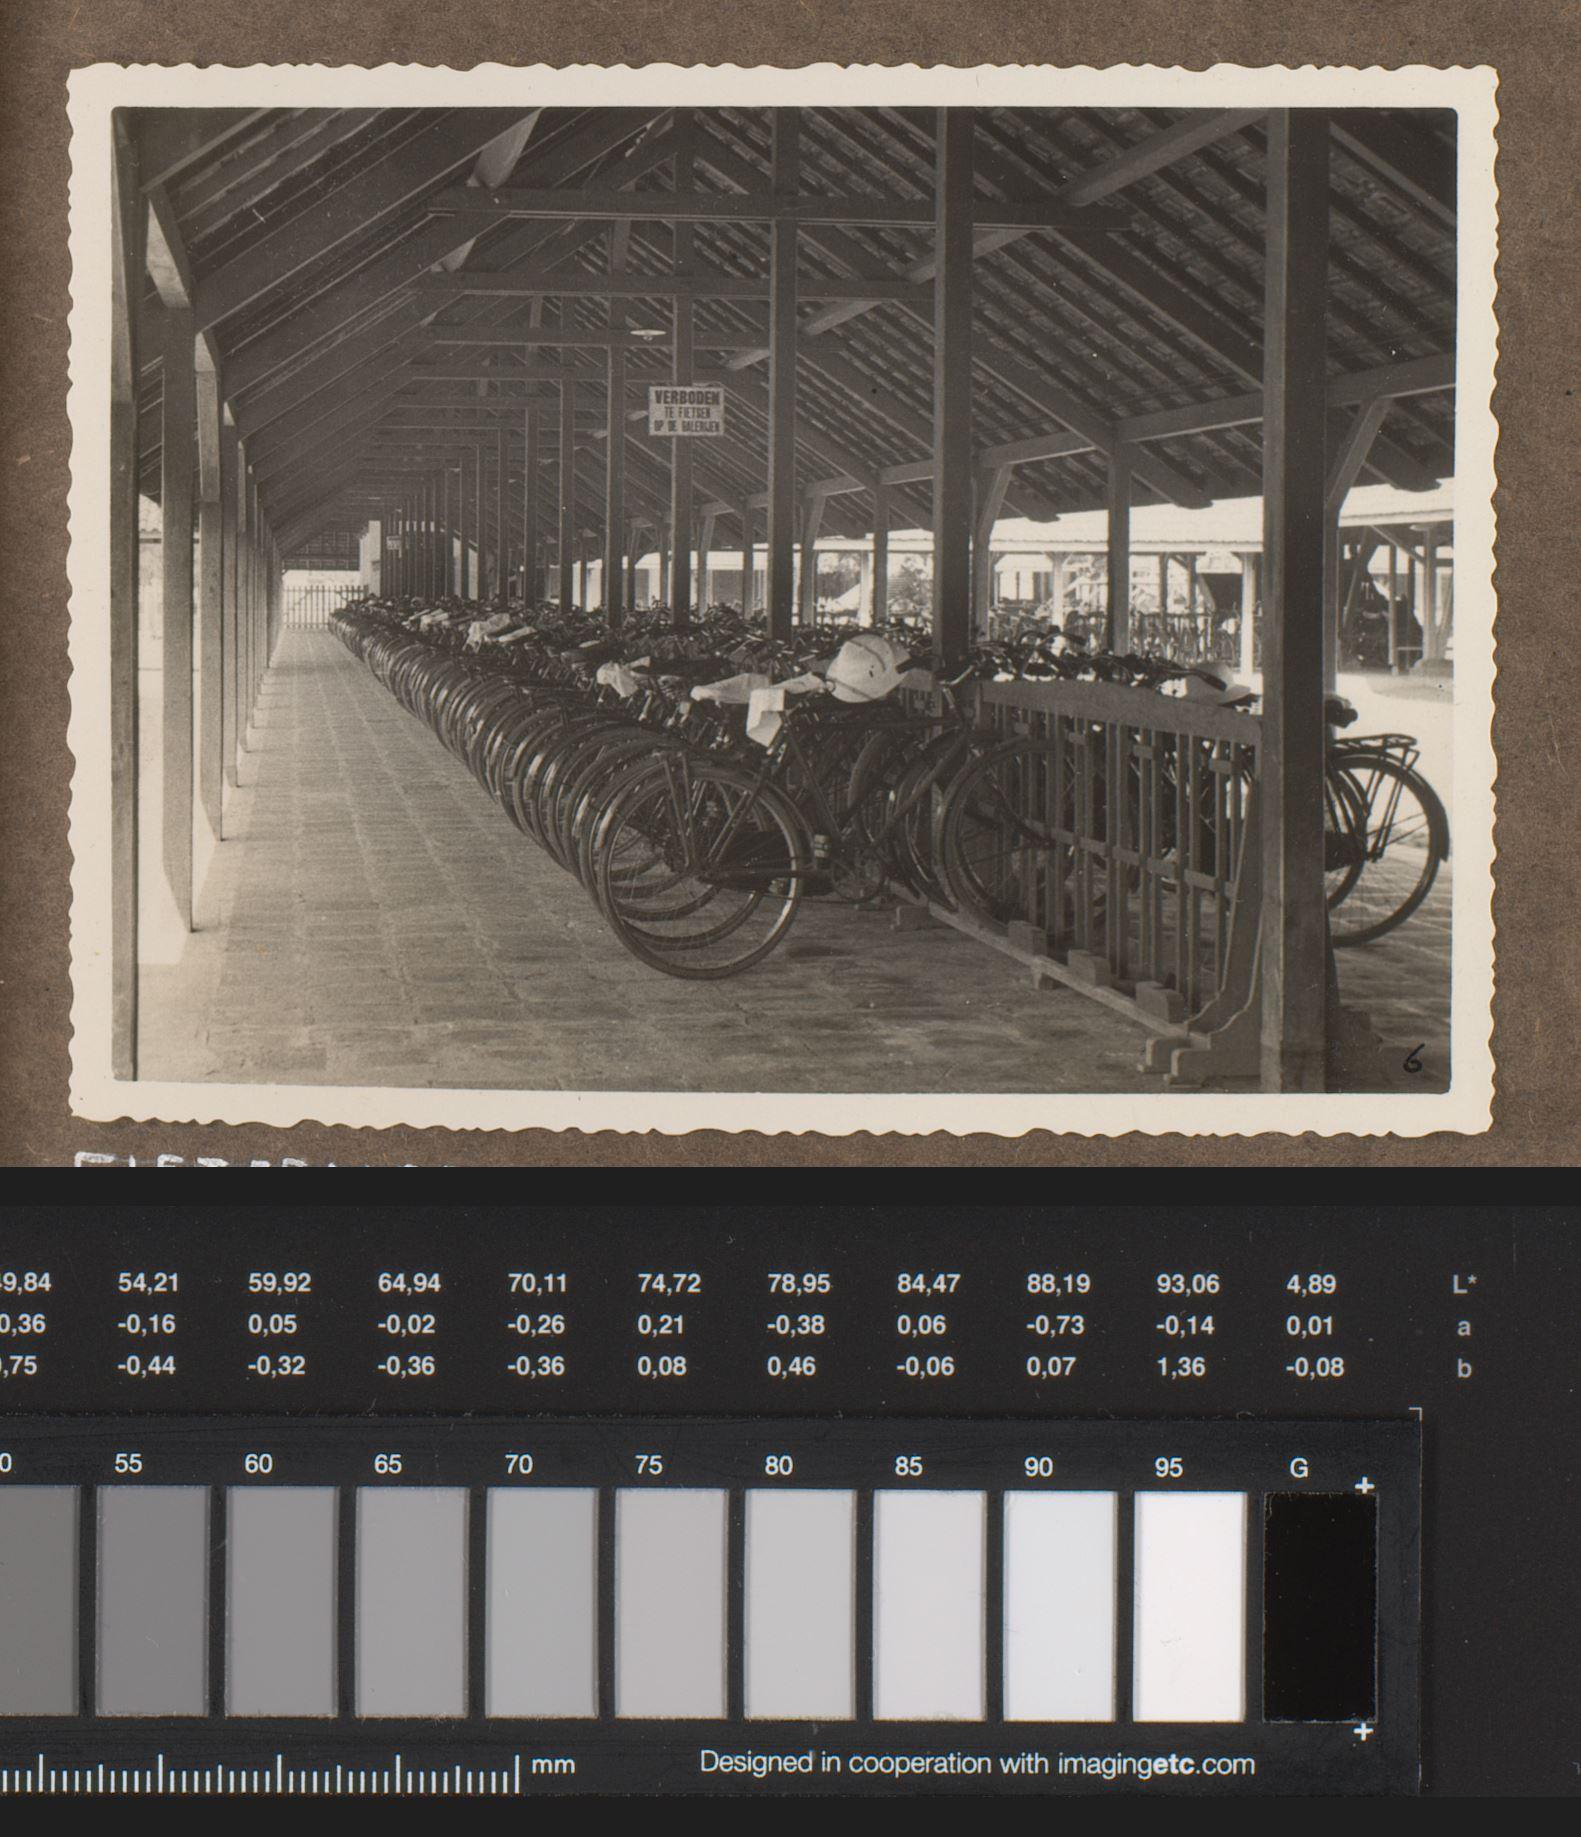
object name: photograph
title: Fietsenrek van de Prinses Juliana School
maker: Anonymous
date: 1933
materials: photographic support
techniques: gelatin silver print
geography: jogjakarta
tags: vocational education, e.g.: junior technical school, bicycle, colonial government, dutch east indies, the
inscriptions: inscription: ‘Fietsenrek / PJS’, inscription: ‘6’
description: Fietsenrek met fietsen bij de Prinses Juliana School te Jogyakarta. Foto ingeplakt in het fotoalbum aangeboden aan J.H.A. van der Hoeven bij het beëindigen op 31 juli 1933 van zijn diensttijd bij het Nijverheidsonderwijs in Nederlandsch-Indië.